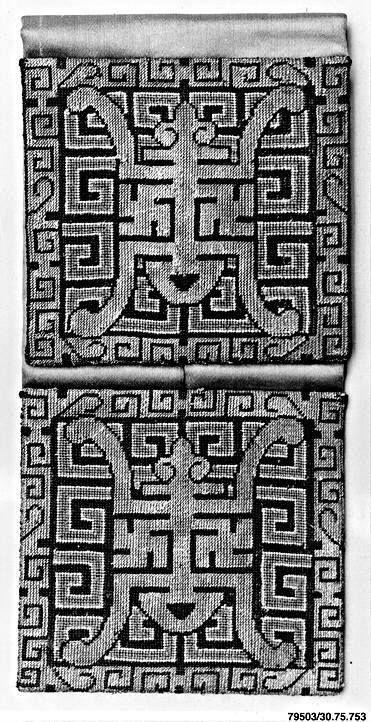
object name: bag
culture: chinese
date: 1701-1900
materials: silk